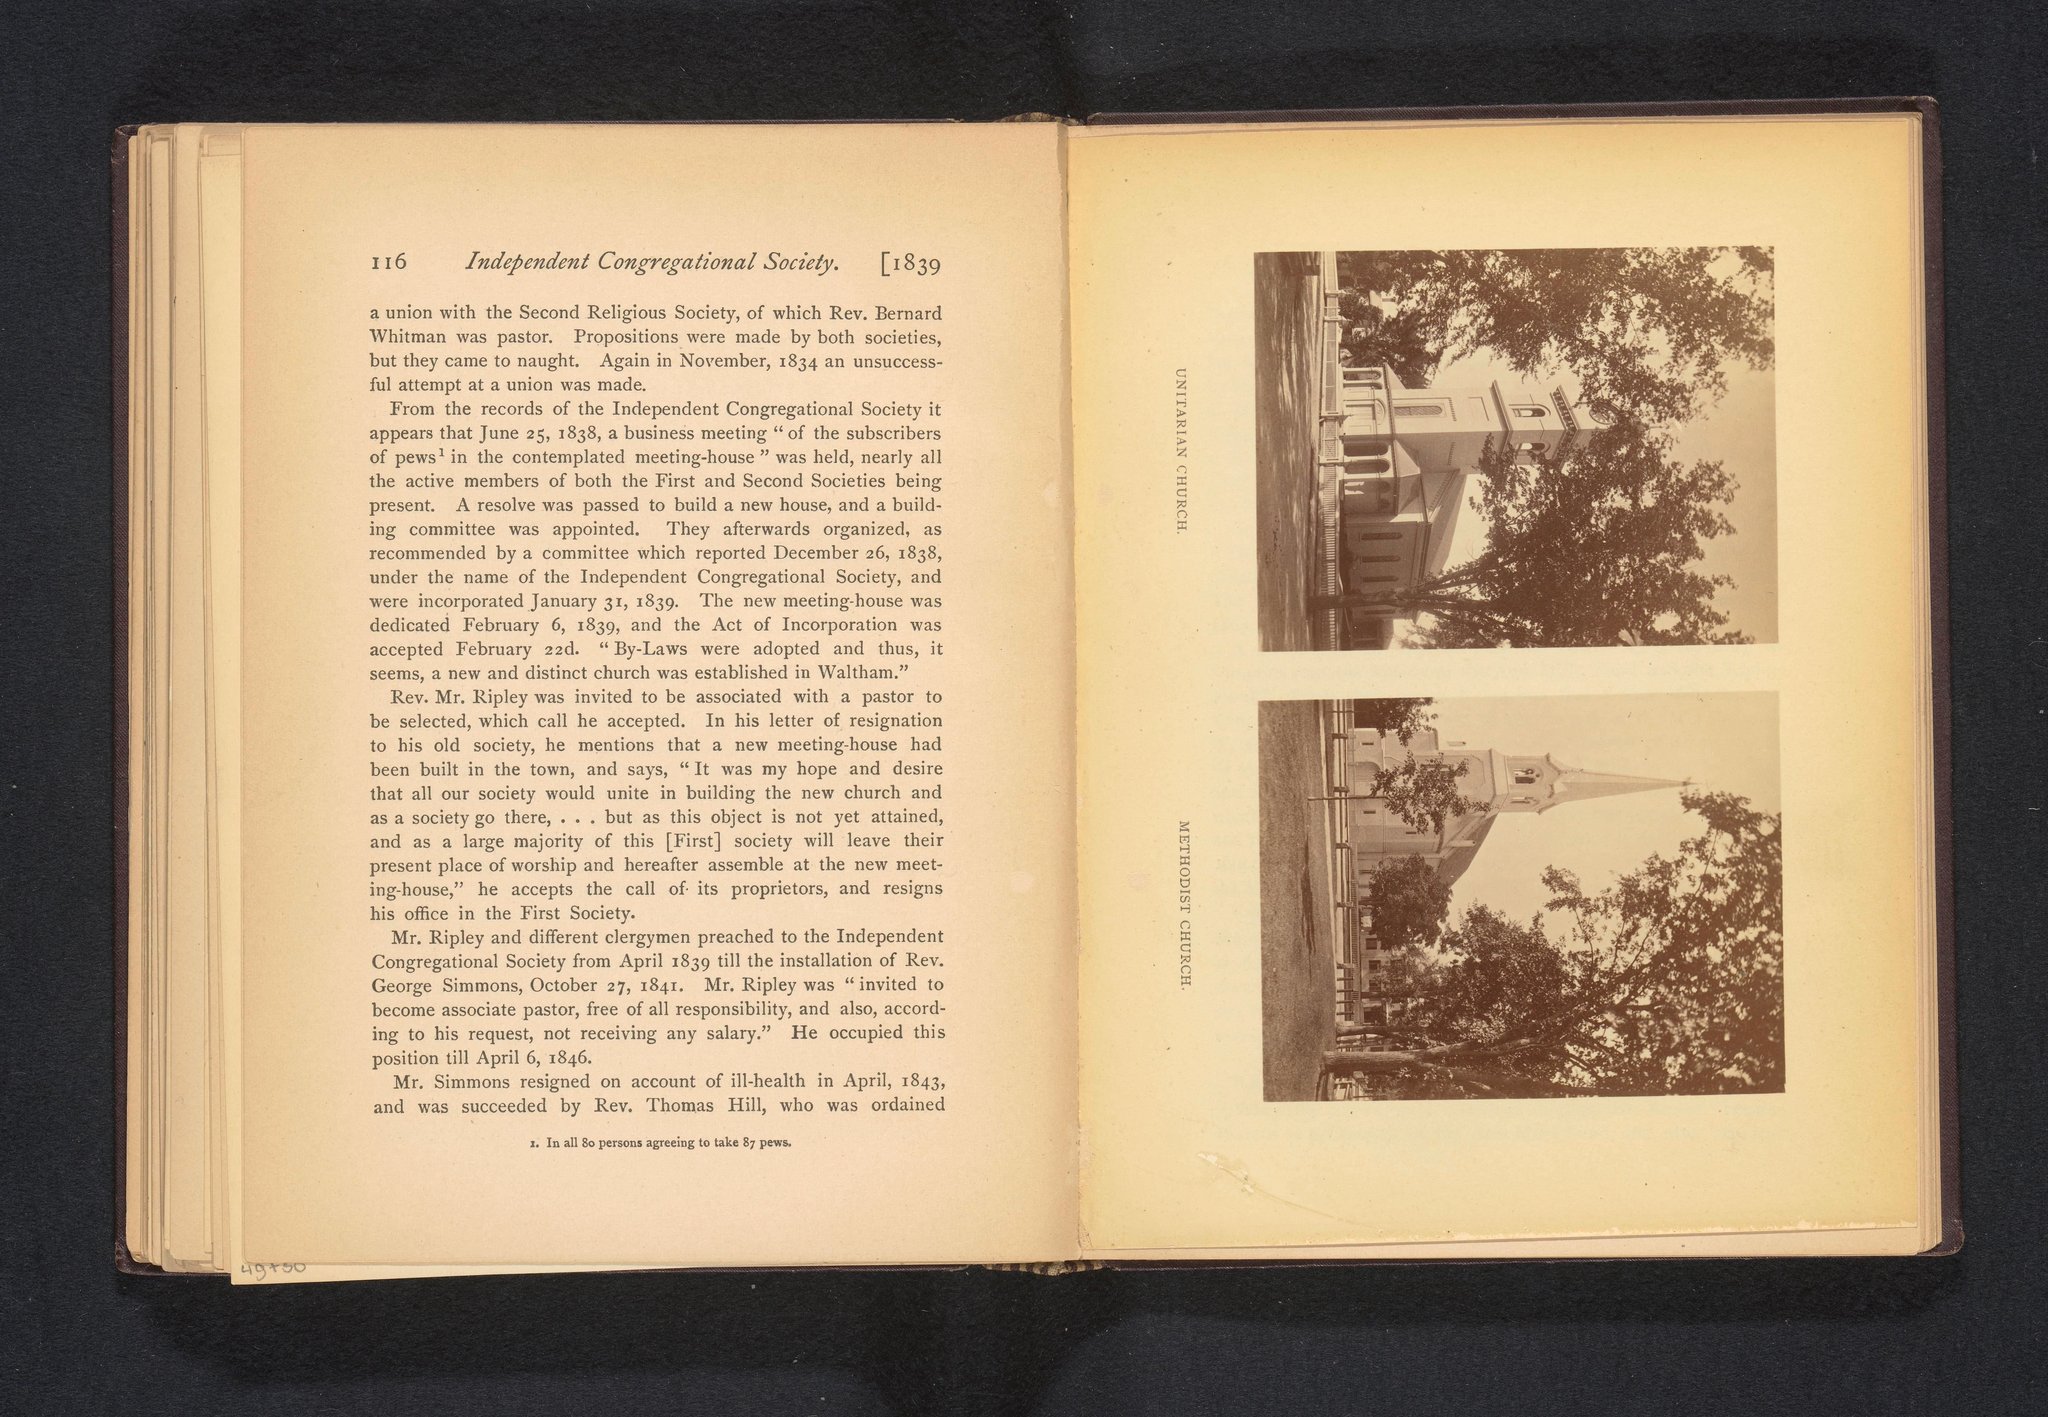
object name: page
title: Gezicht op een methodistische kerk in Waltham, Massachusetts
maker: thomas r. lewis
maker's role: publisher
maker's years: 1845-1901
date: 1874-1879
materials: photographic support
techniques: albumen print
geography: waltham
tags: church (exterior)